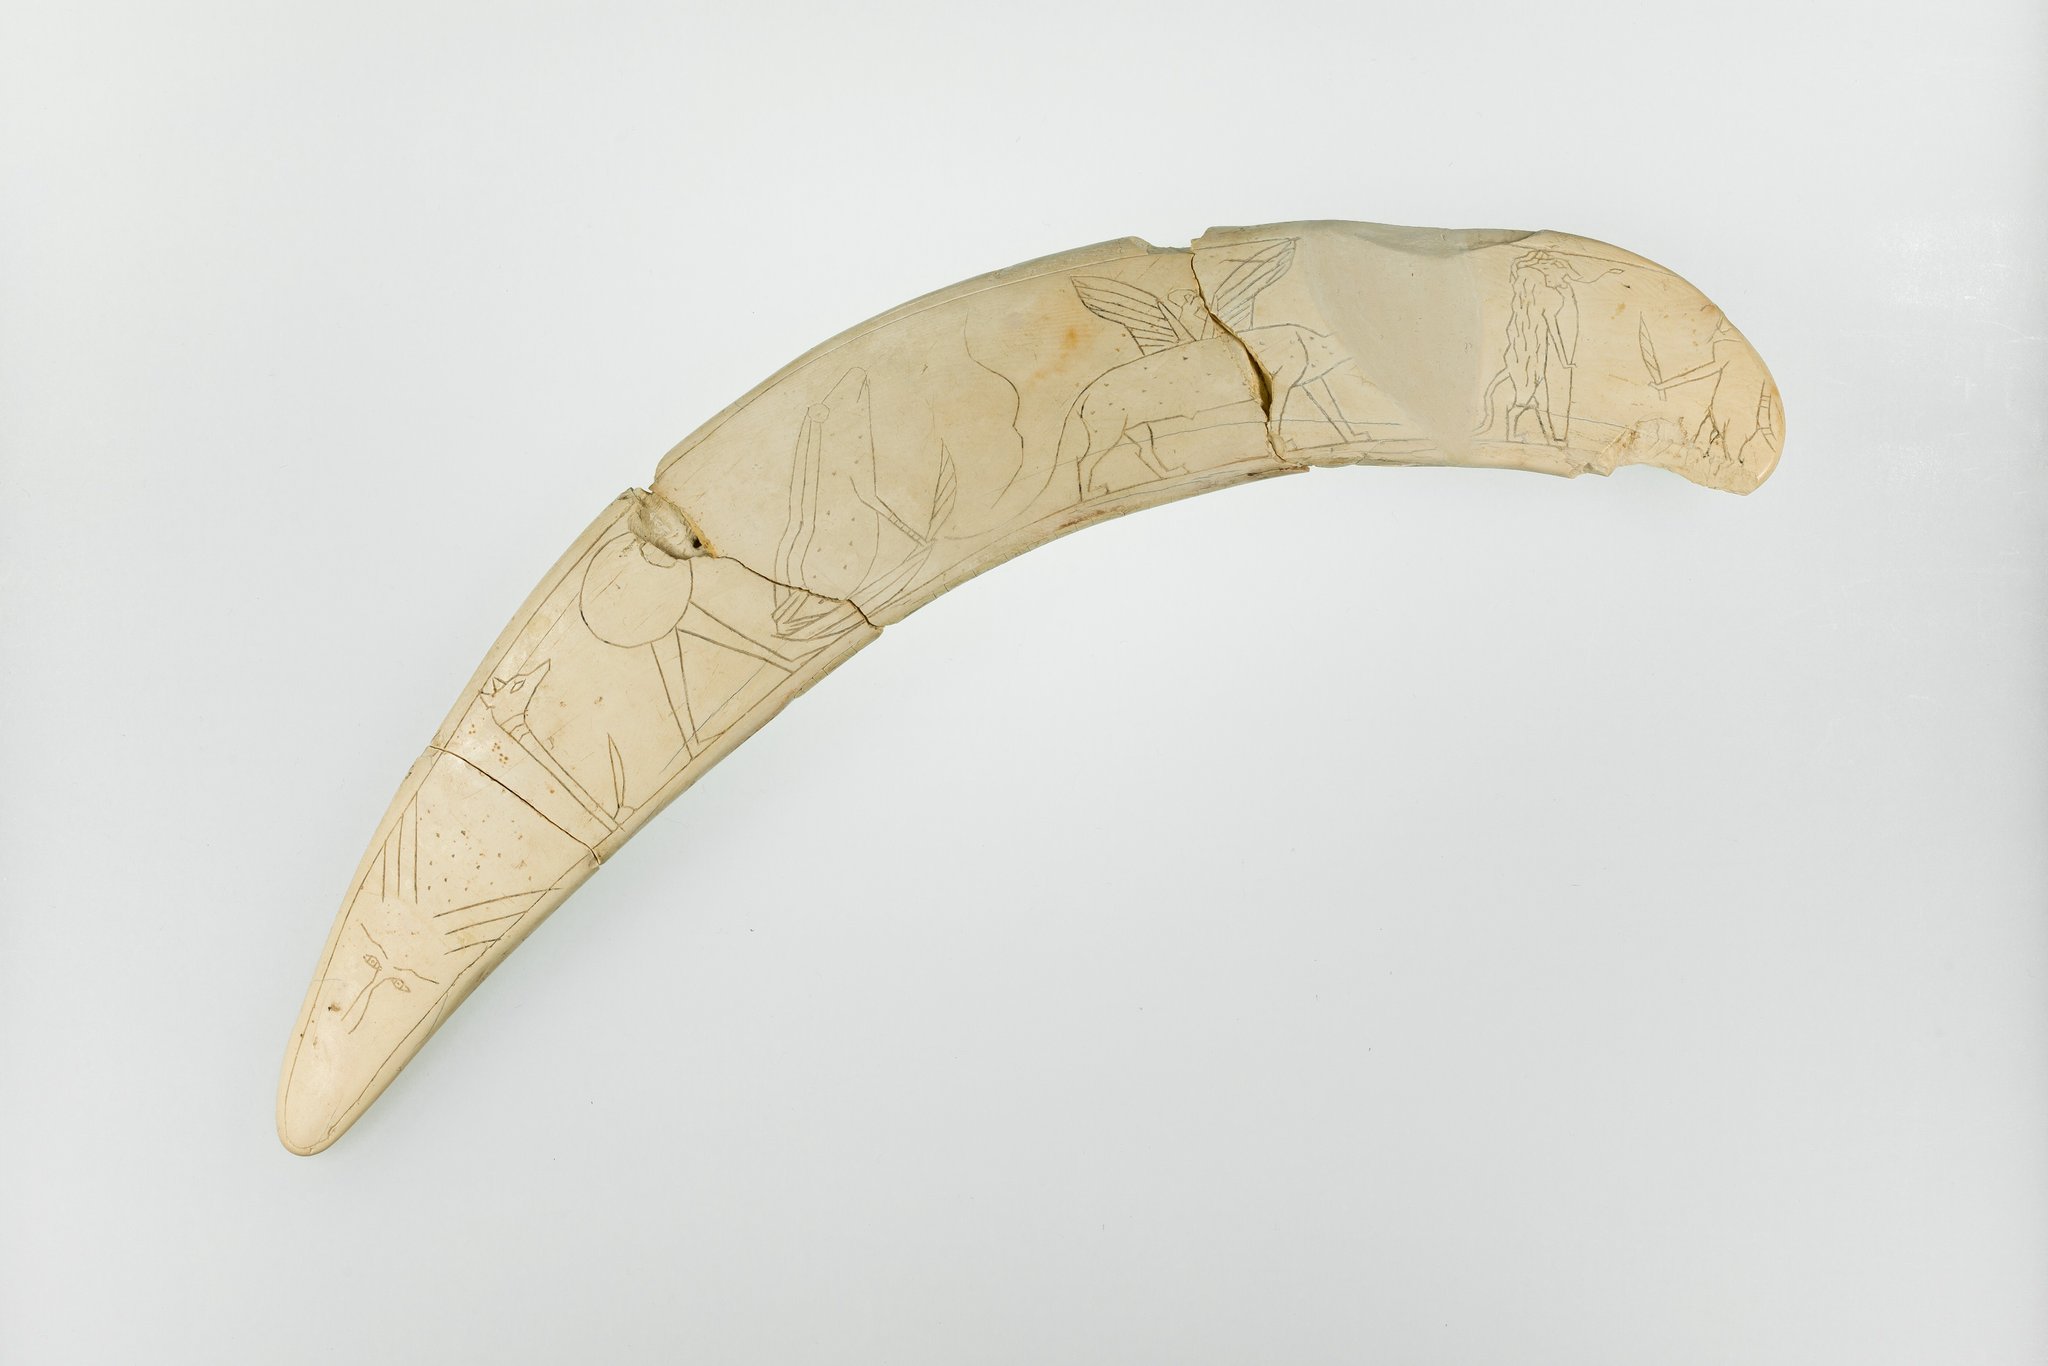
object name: magic wand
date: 1981-1640 BCE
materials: ivory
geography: egypt